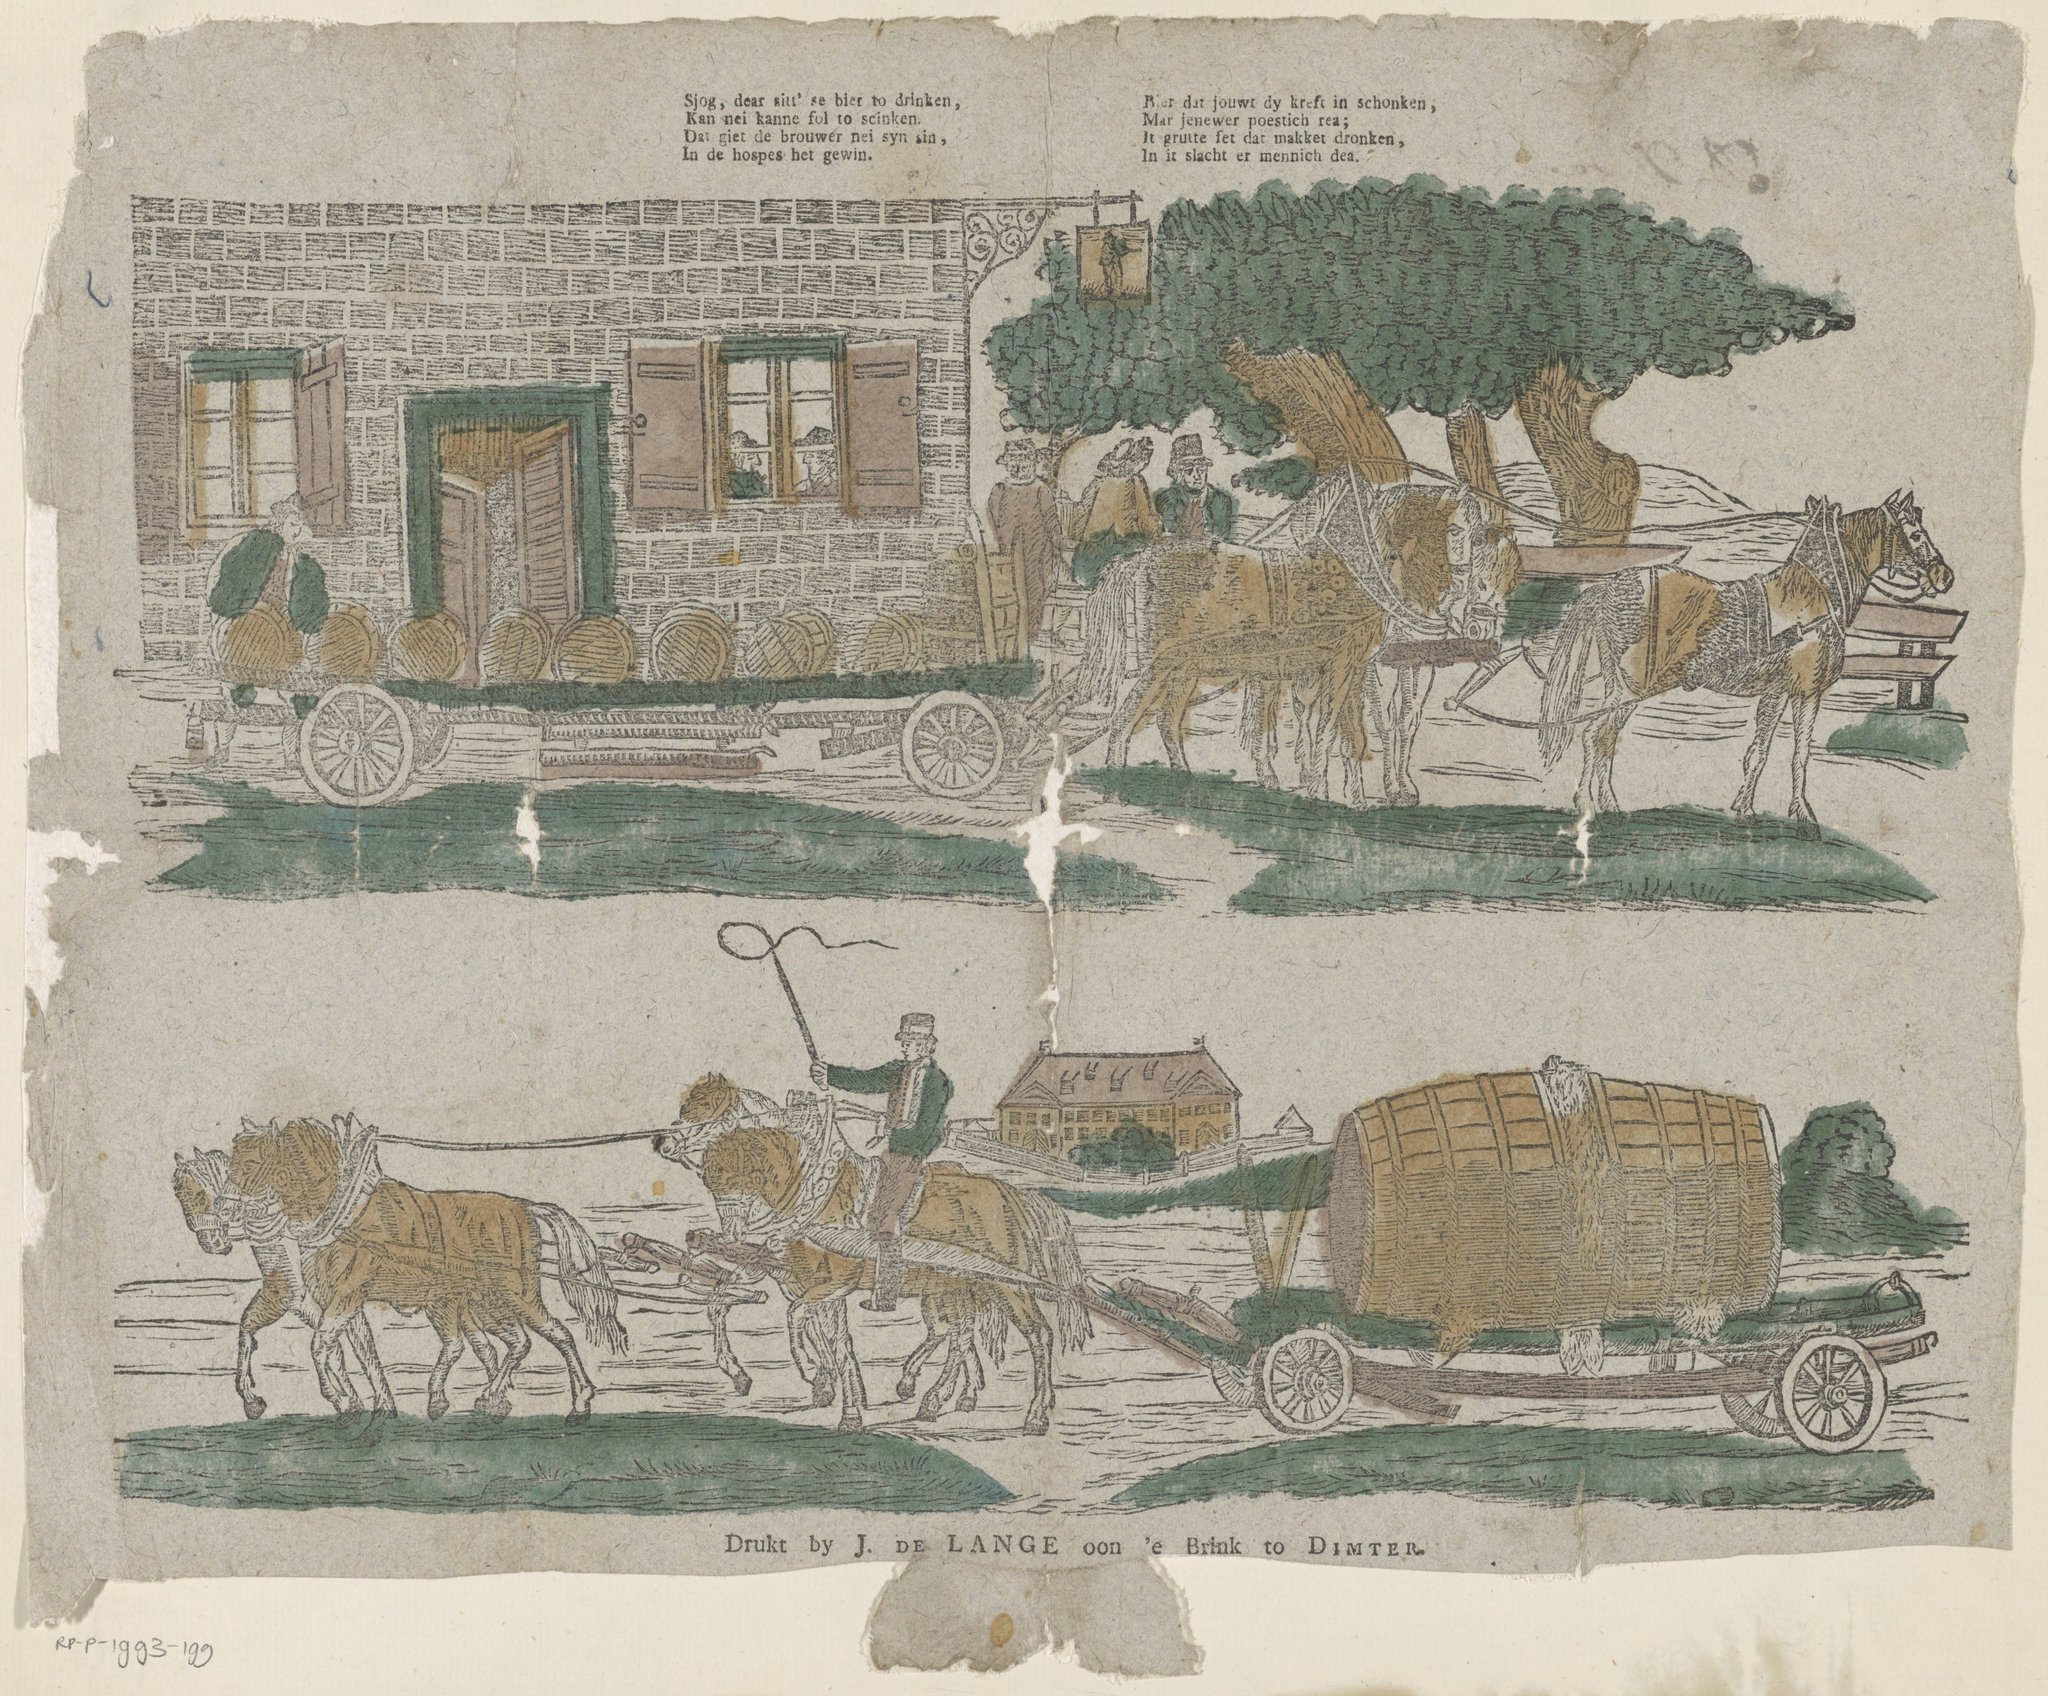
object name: print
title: Sjog, dear sitt'se bier to drinken, / Kan nei kanne fol to seinken [(...)]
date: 1822-1849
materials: paper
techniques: colour, letterpress printing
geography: deventer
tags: traffic and transport, beer, ale (+ foodstuffs in other container, e.g.: barrel, can, cask, tin, etc.), hotel, hostelry, inn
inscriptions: collector's mark: Lugt 2228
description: Blad met 2 voorstellingen van bierwagens. Boven een achtregelig vers in het Fries.